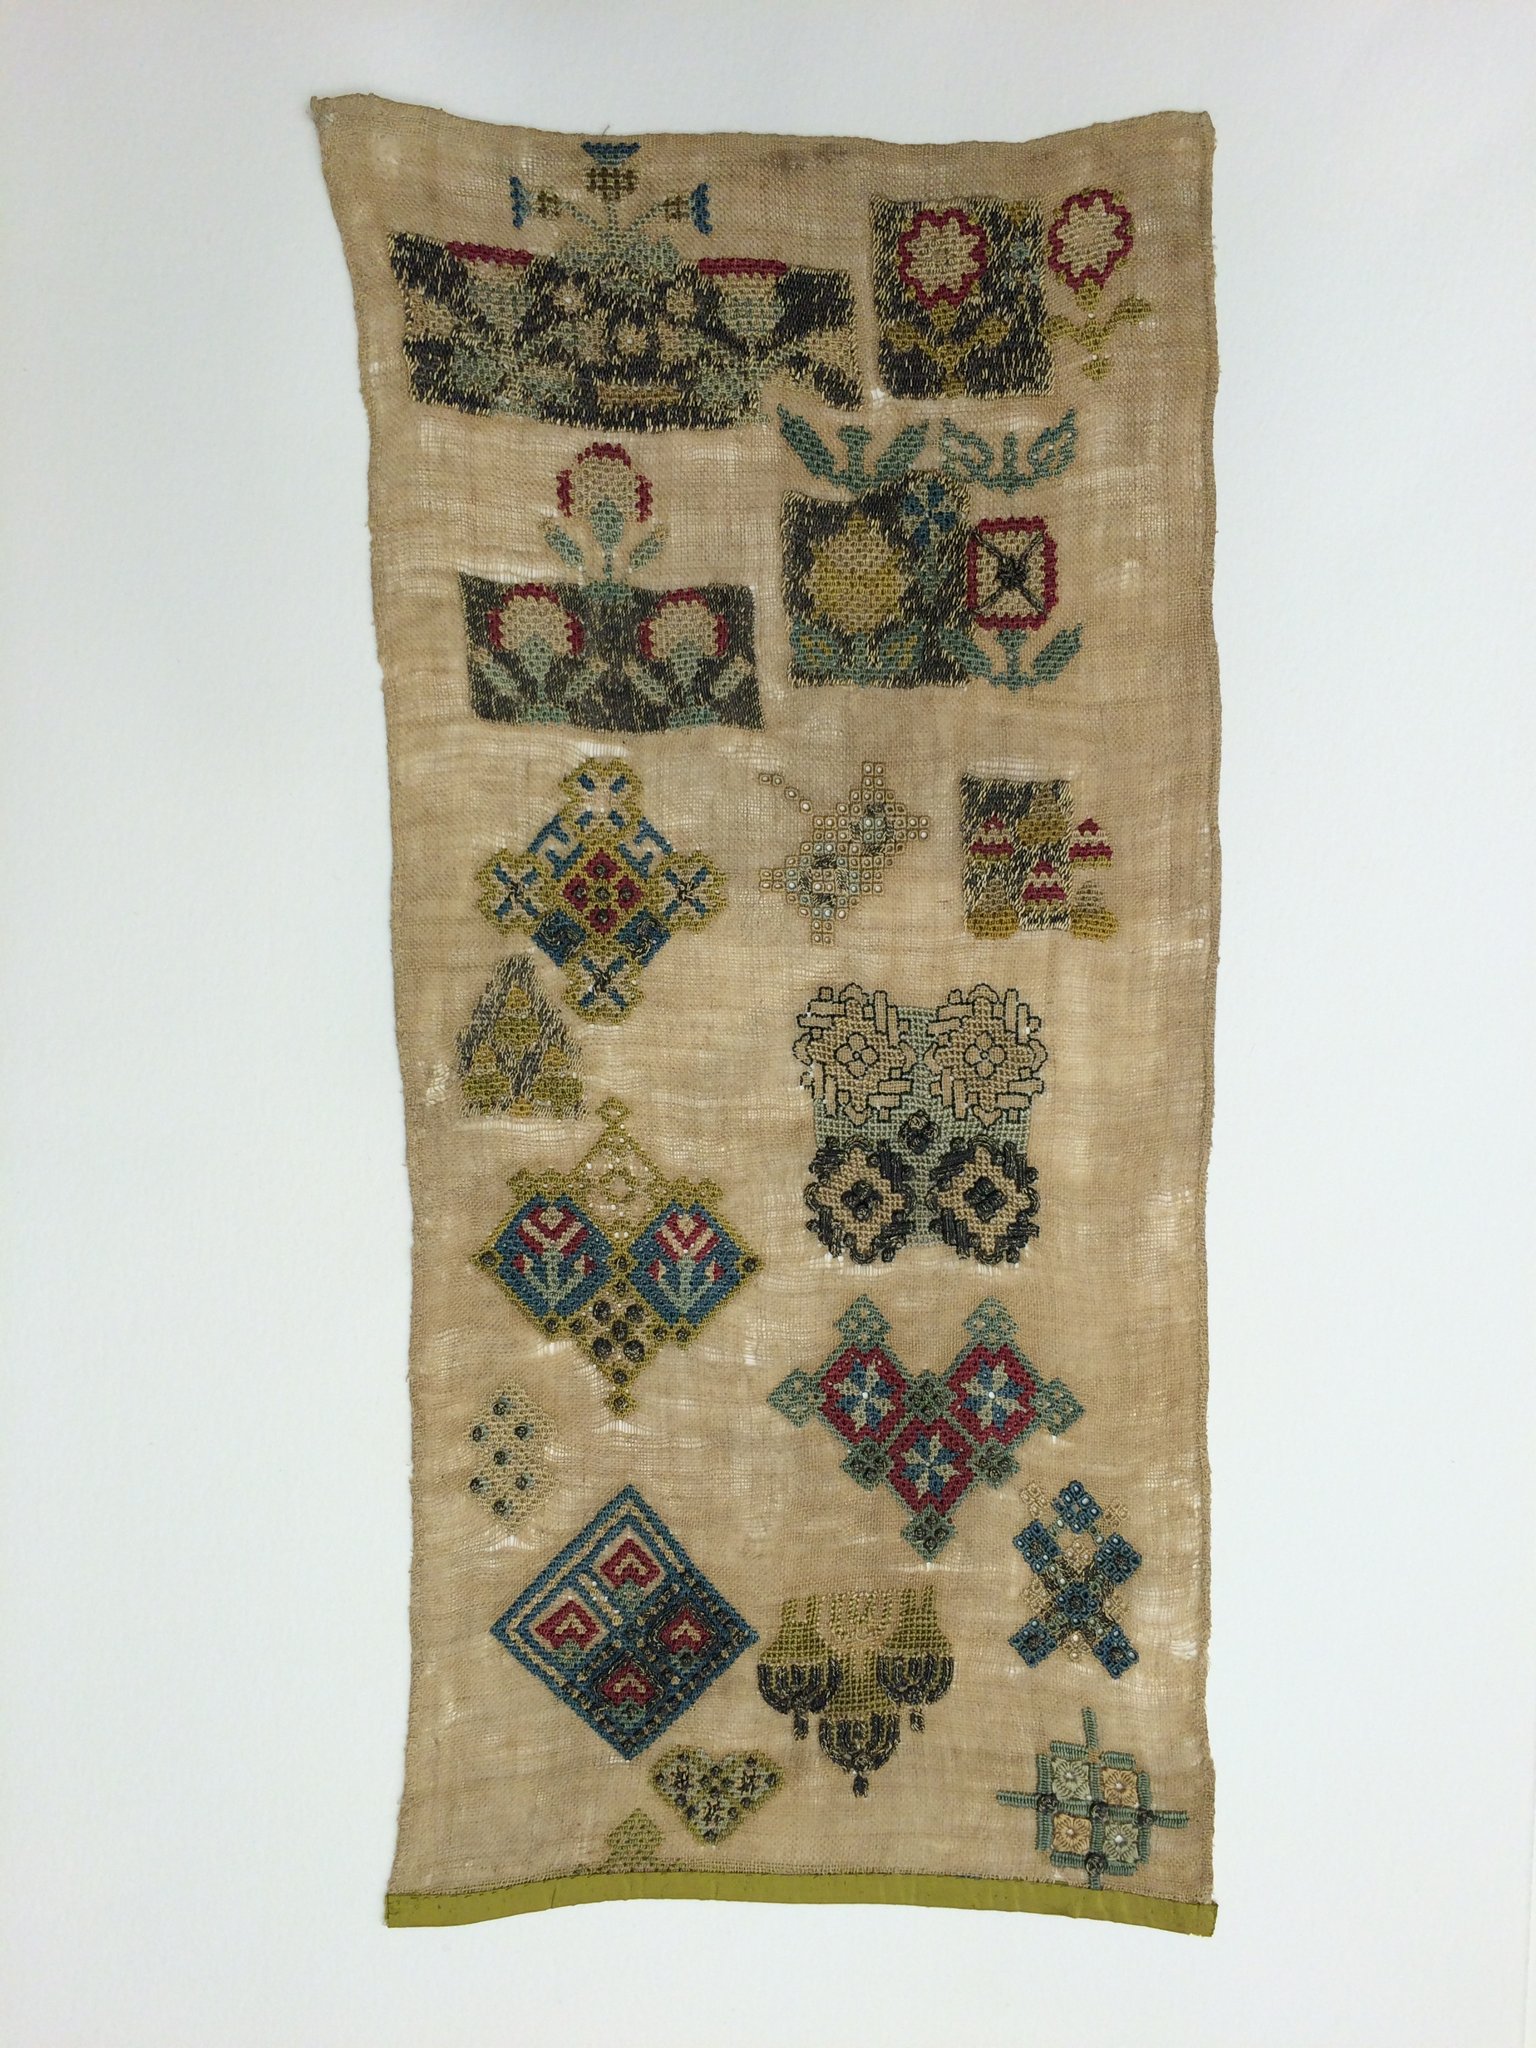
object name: sampler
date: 1601-1650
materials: linen, metal thread, silk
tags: flowers